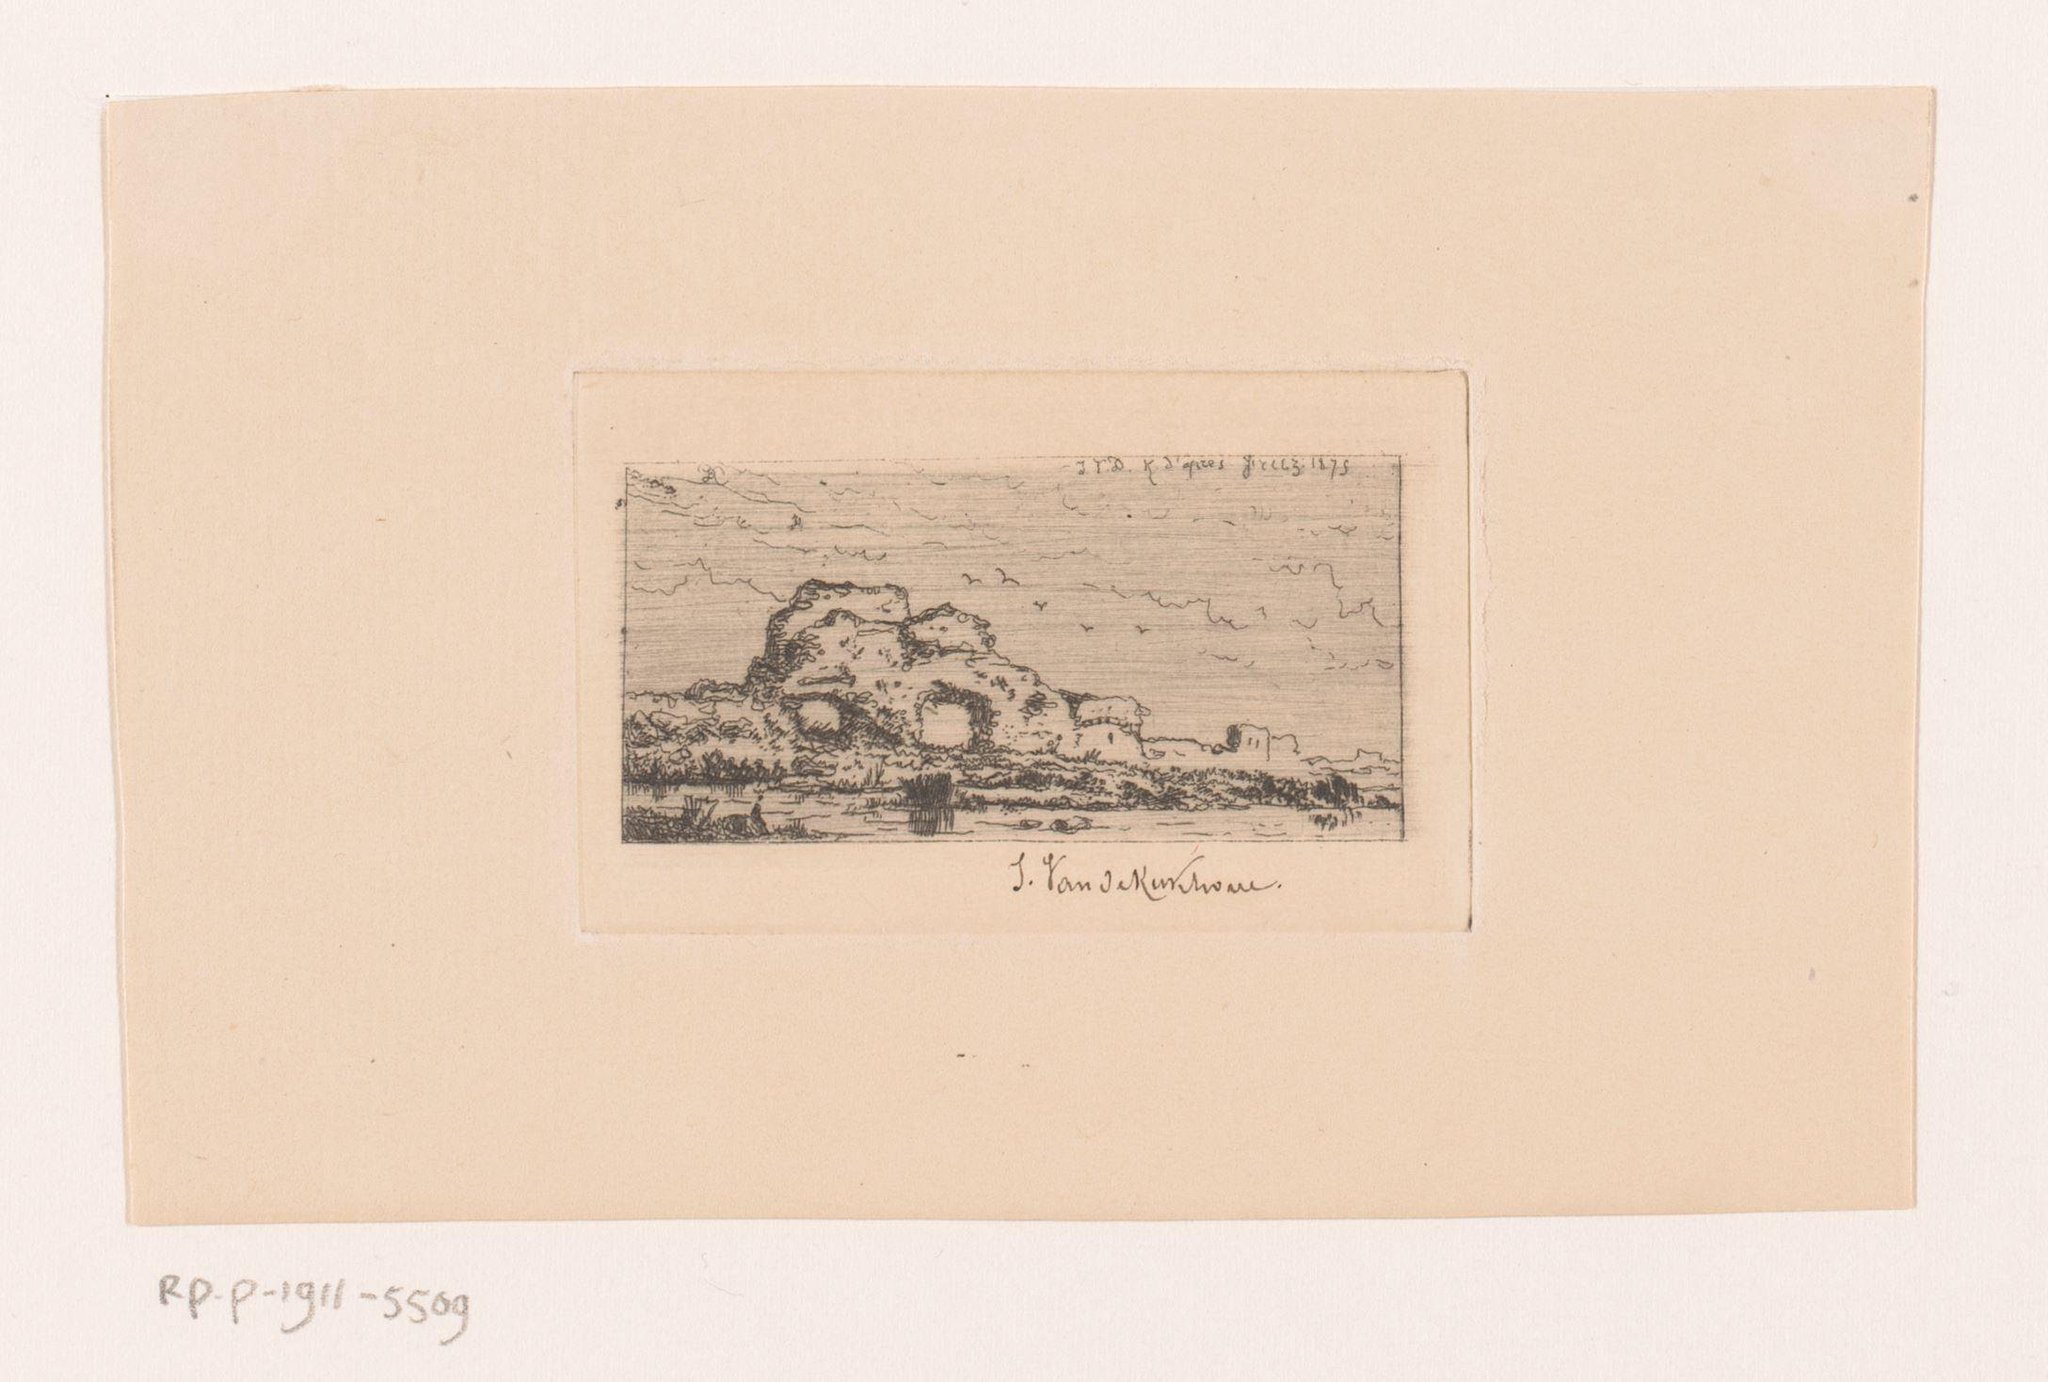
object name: print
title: Landschap met boogvormige ruïne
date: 1873-1881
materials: paper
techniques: etching, intaglio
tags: landscape with ruins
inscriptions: collector's mark: Lugt 2228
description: De etsen naar de schilderijen van Frédéric Van de Kerkhove werden na zijn dood door zijn vader en zuster gemaakt en uitgegeven in twee reeksen. De eerste werd in 1877 uitgegeven door het Journal des Beaux-Arts et de la Littérature: Cahier de 25 Eaux-fortes d'après Frédéric van de Kerkhove, gravées par son père et sa sœur. De tweede reeks van 126 etsen, ook in 1877, werd in Parijs uitgegeven bij A. Lévy onder de titel Cent eaux-fortes gravées par J. Van de Kerkhove d'après les tableaux de Frédéric Van de Kerkhove, mort en 1873 à l'âge de 10 ans et 11 mois.